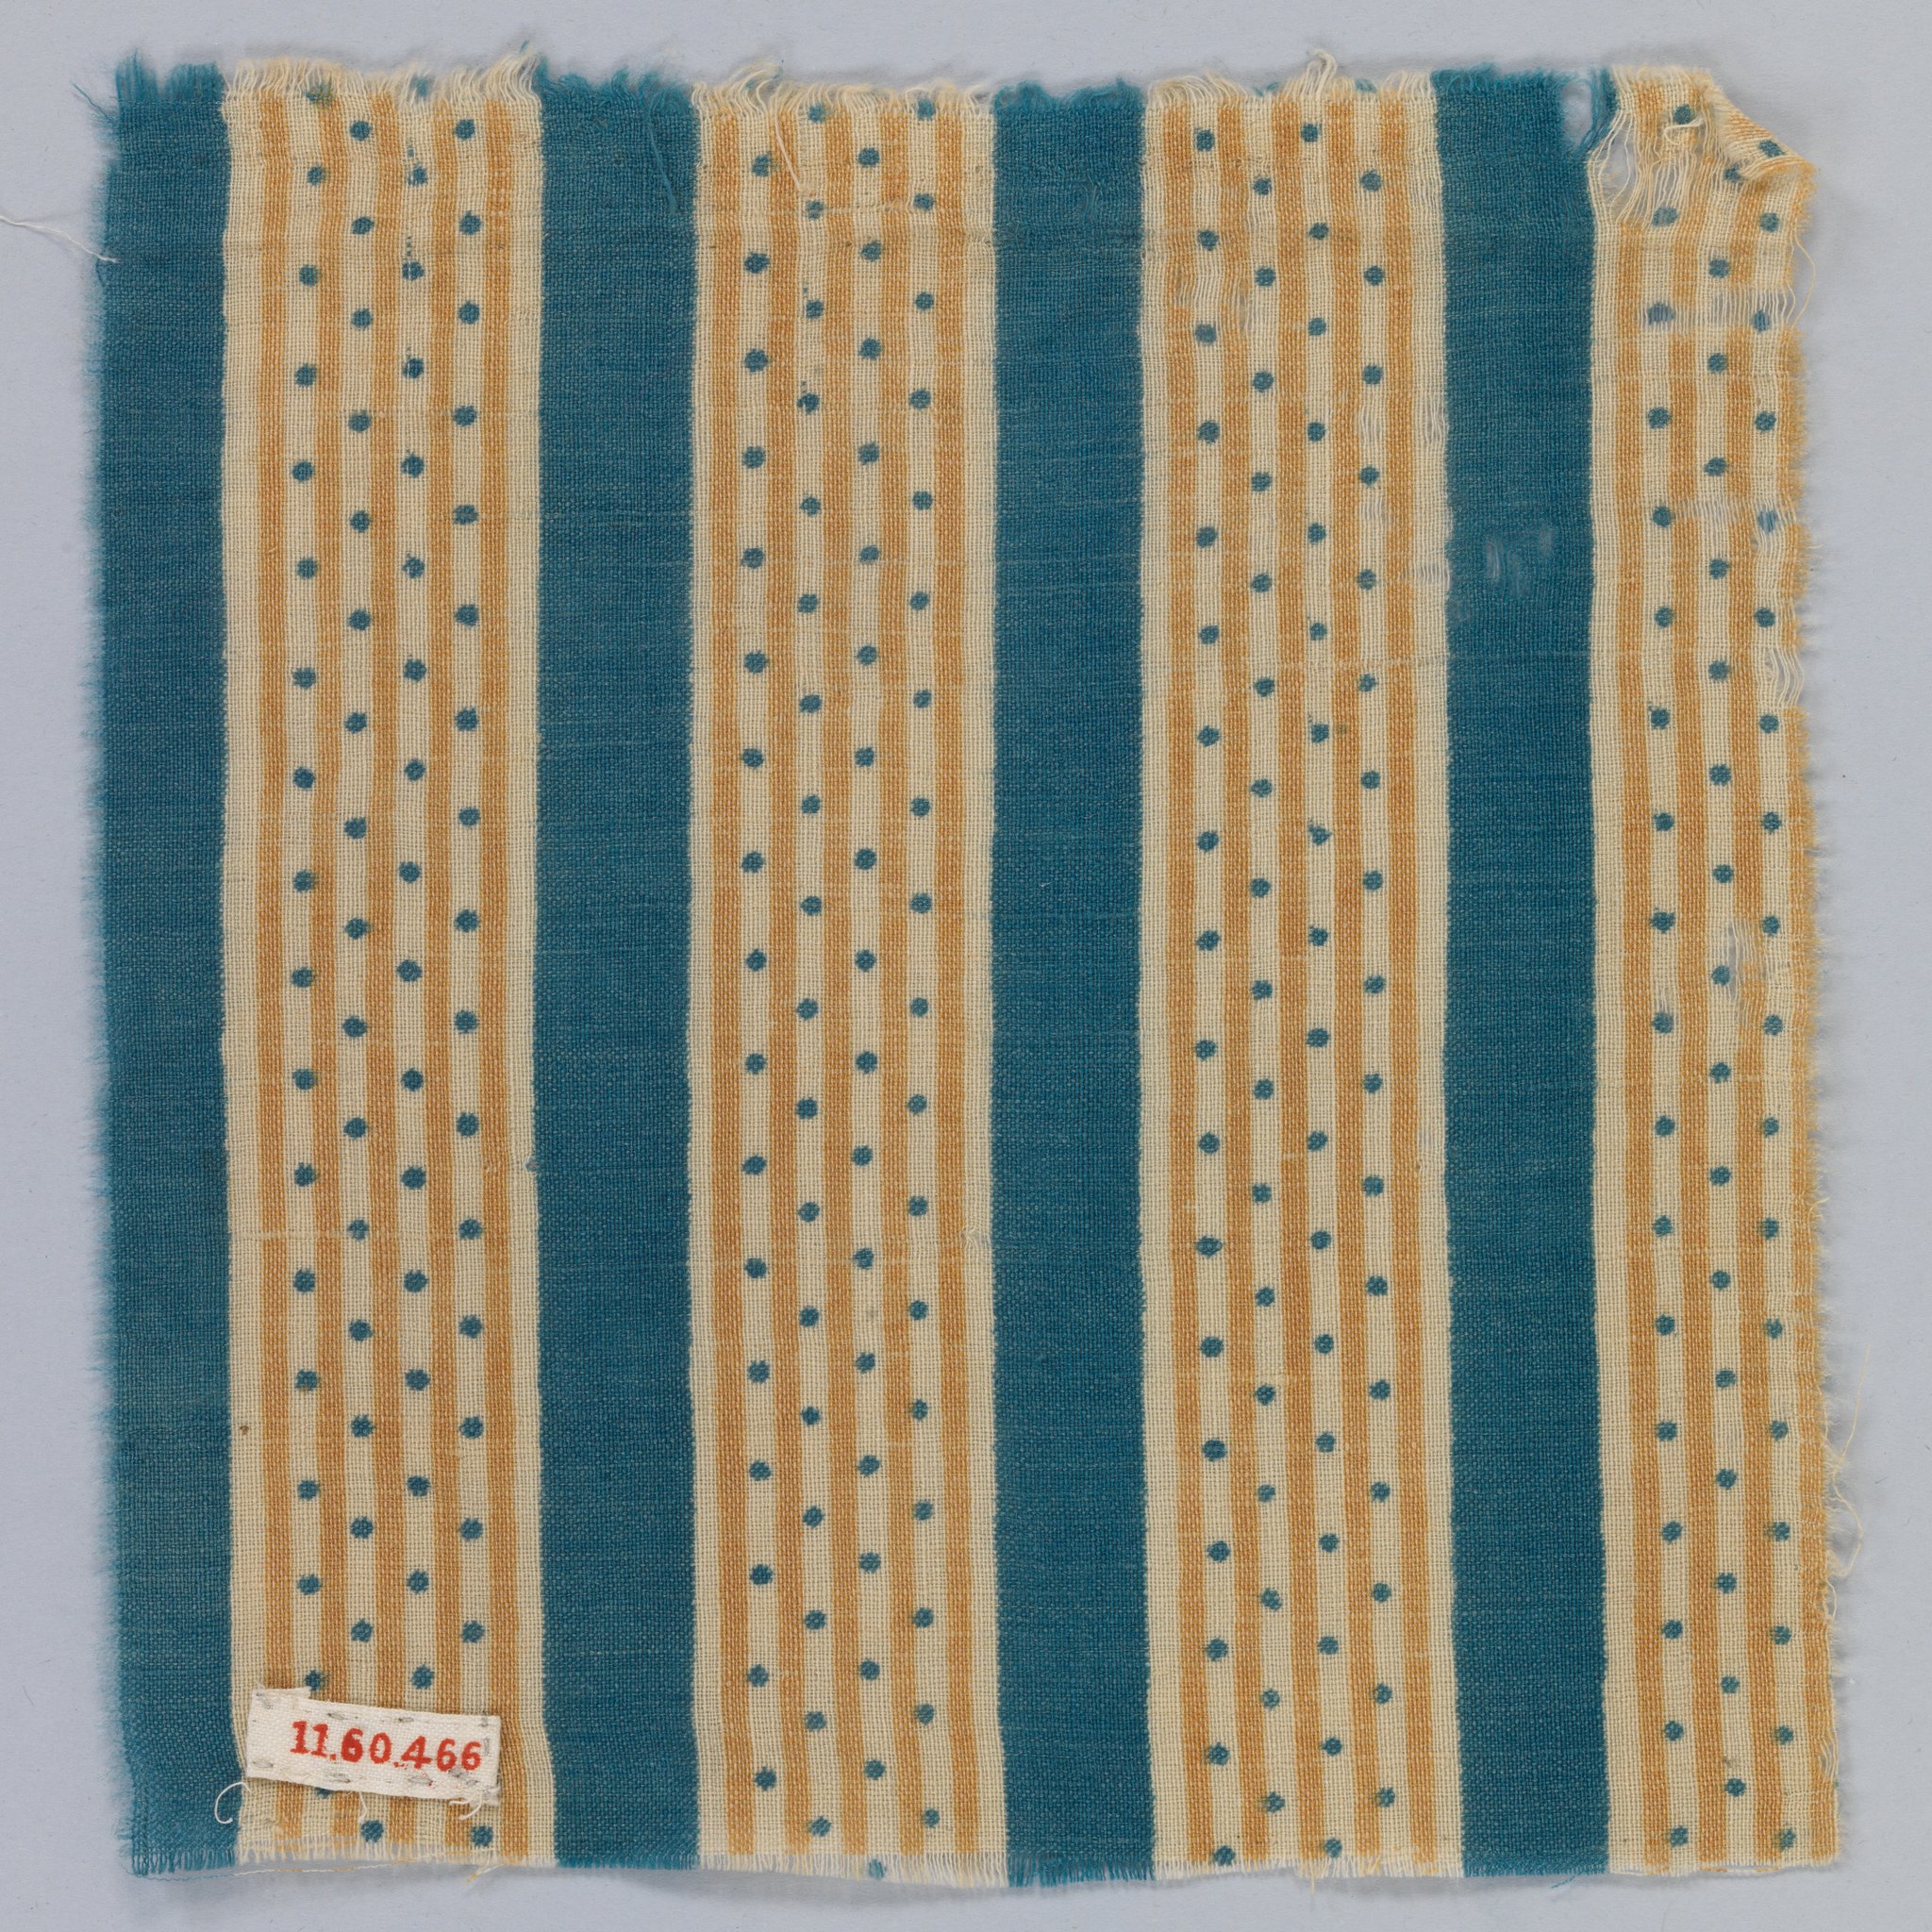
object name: piece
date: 1801-1900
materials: cotton